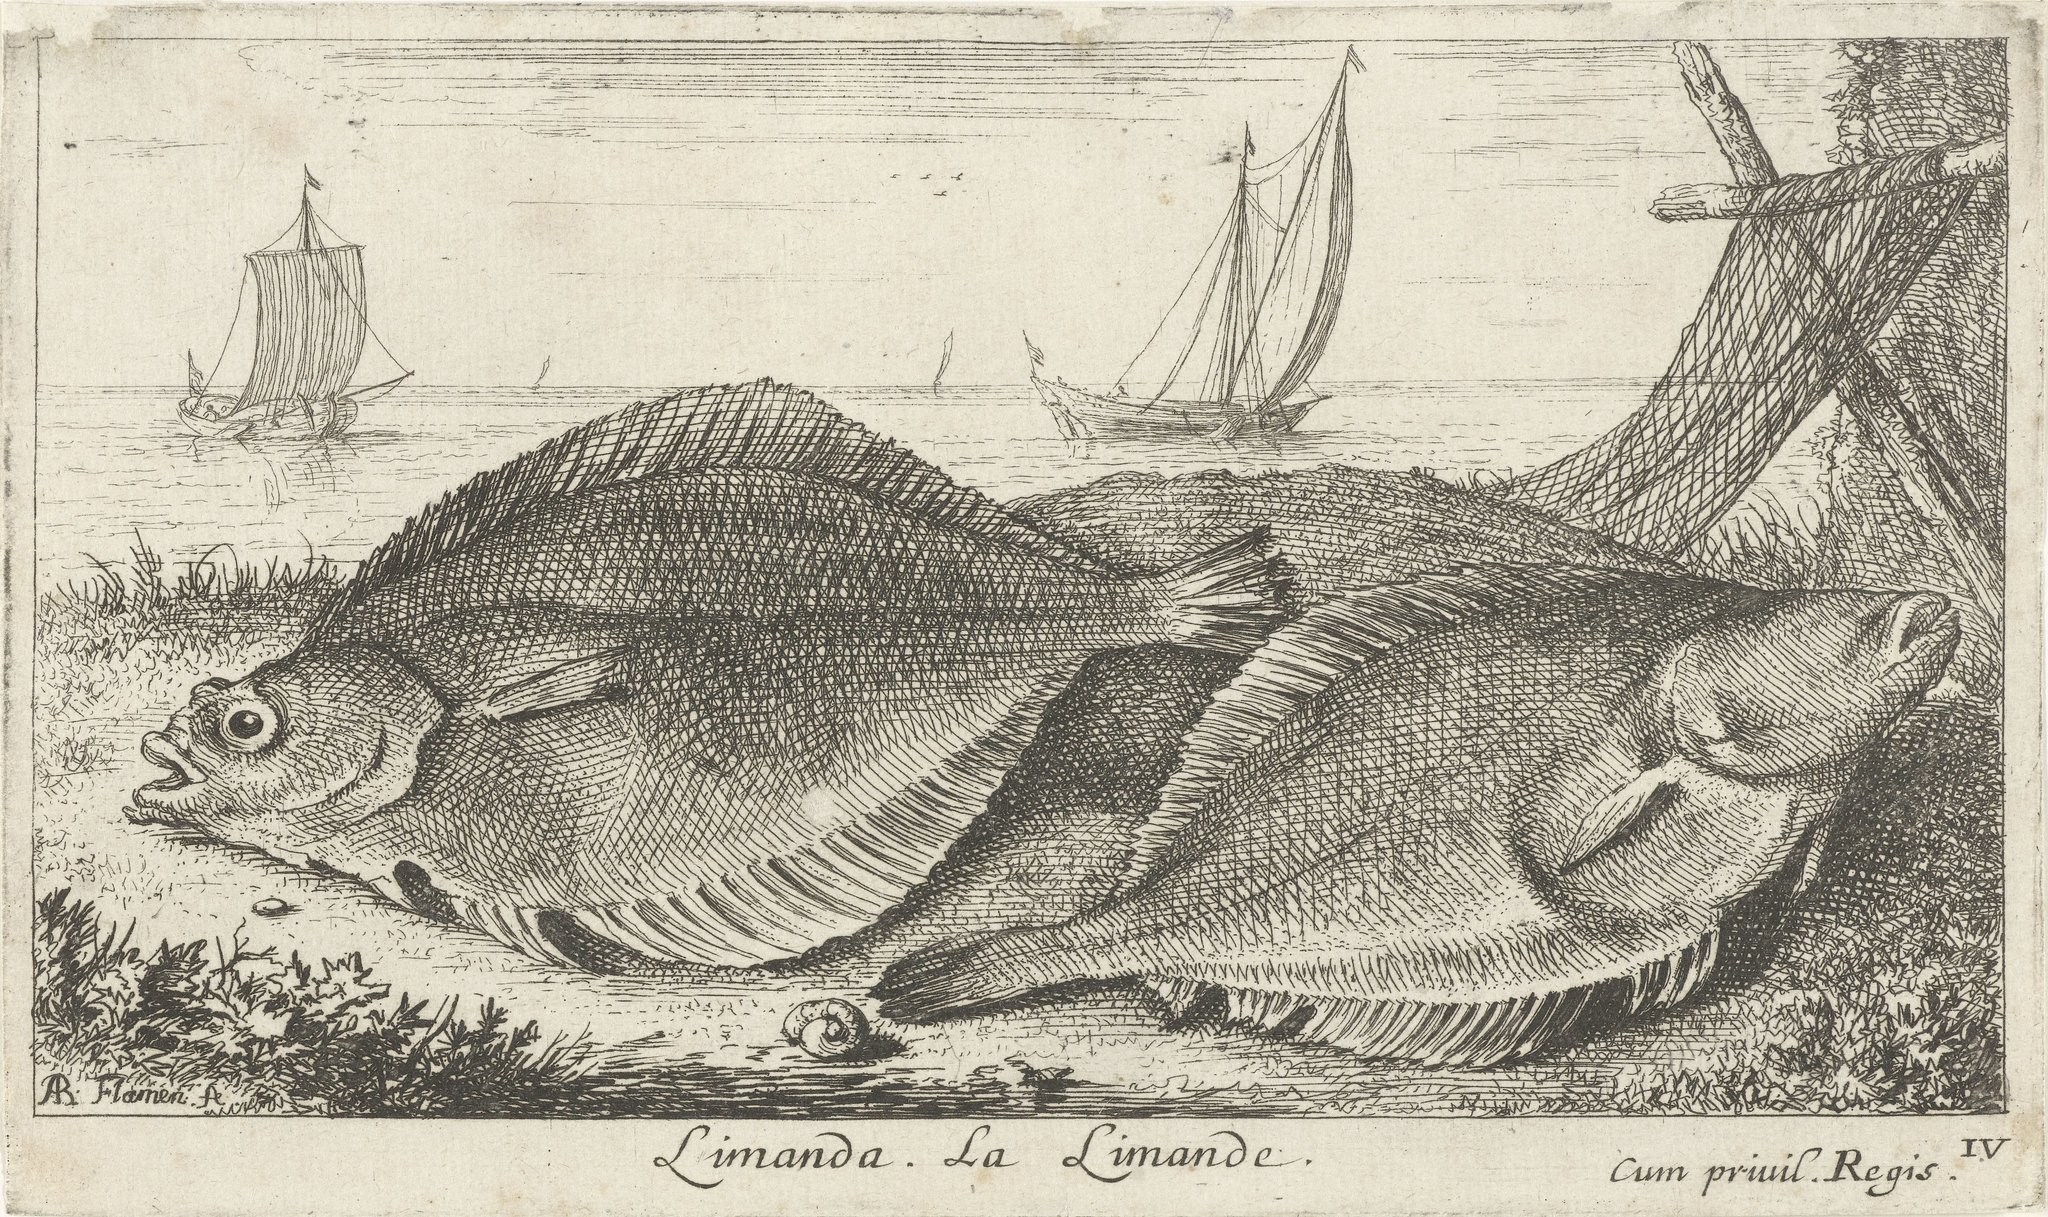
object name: print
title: Limanda. La Limande.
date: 1664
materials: paper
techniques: etching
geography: paris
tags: fishes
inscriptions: collector's mark: Lugt 2228